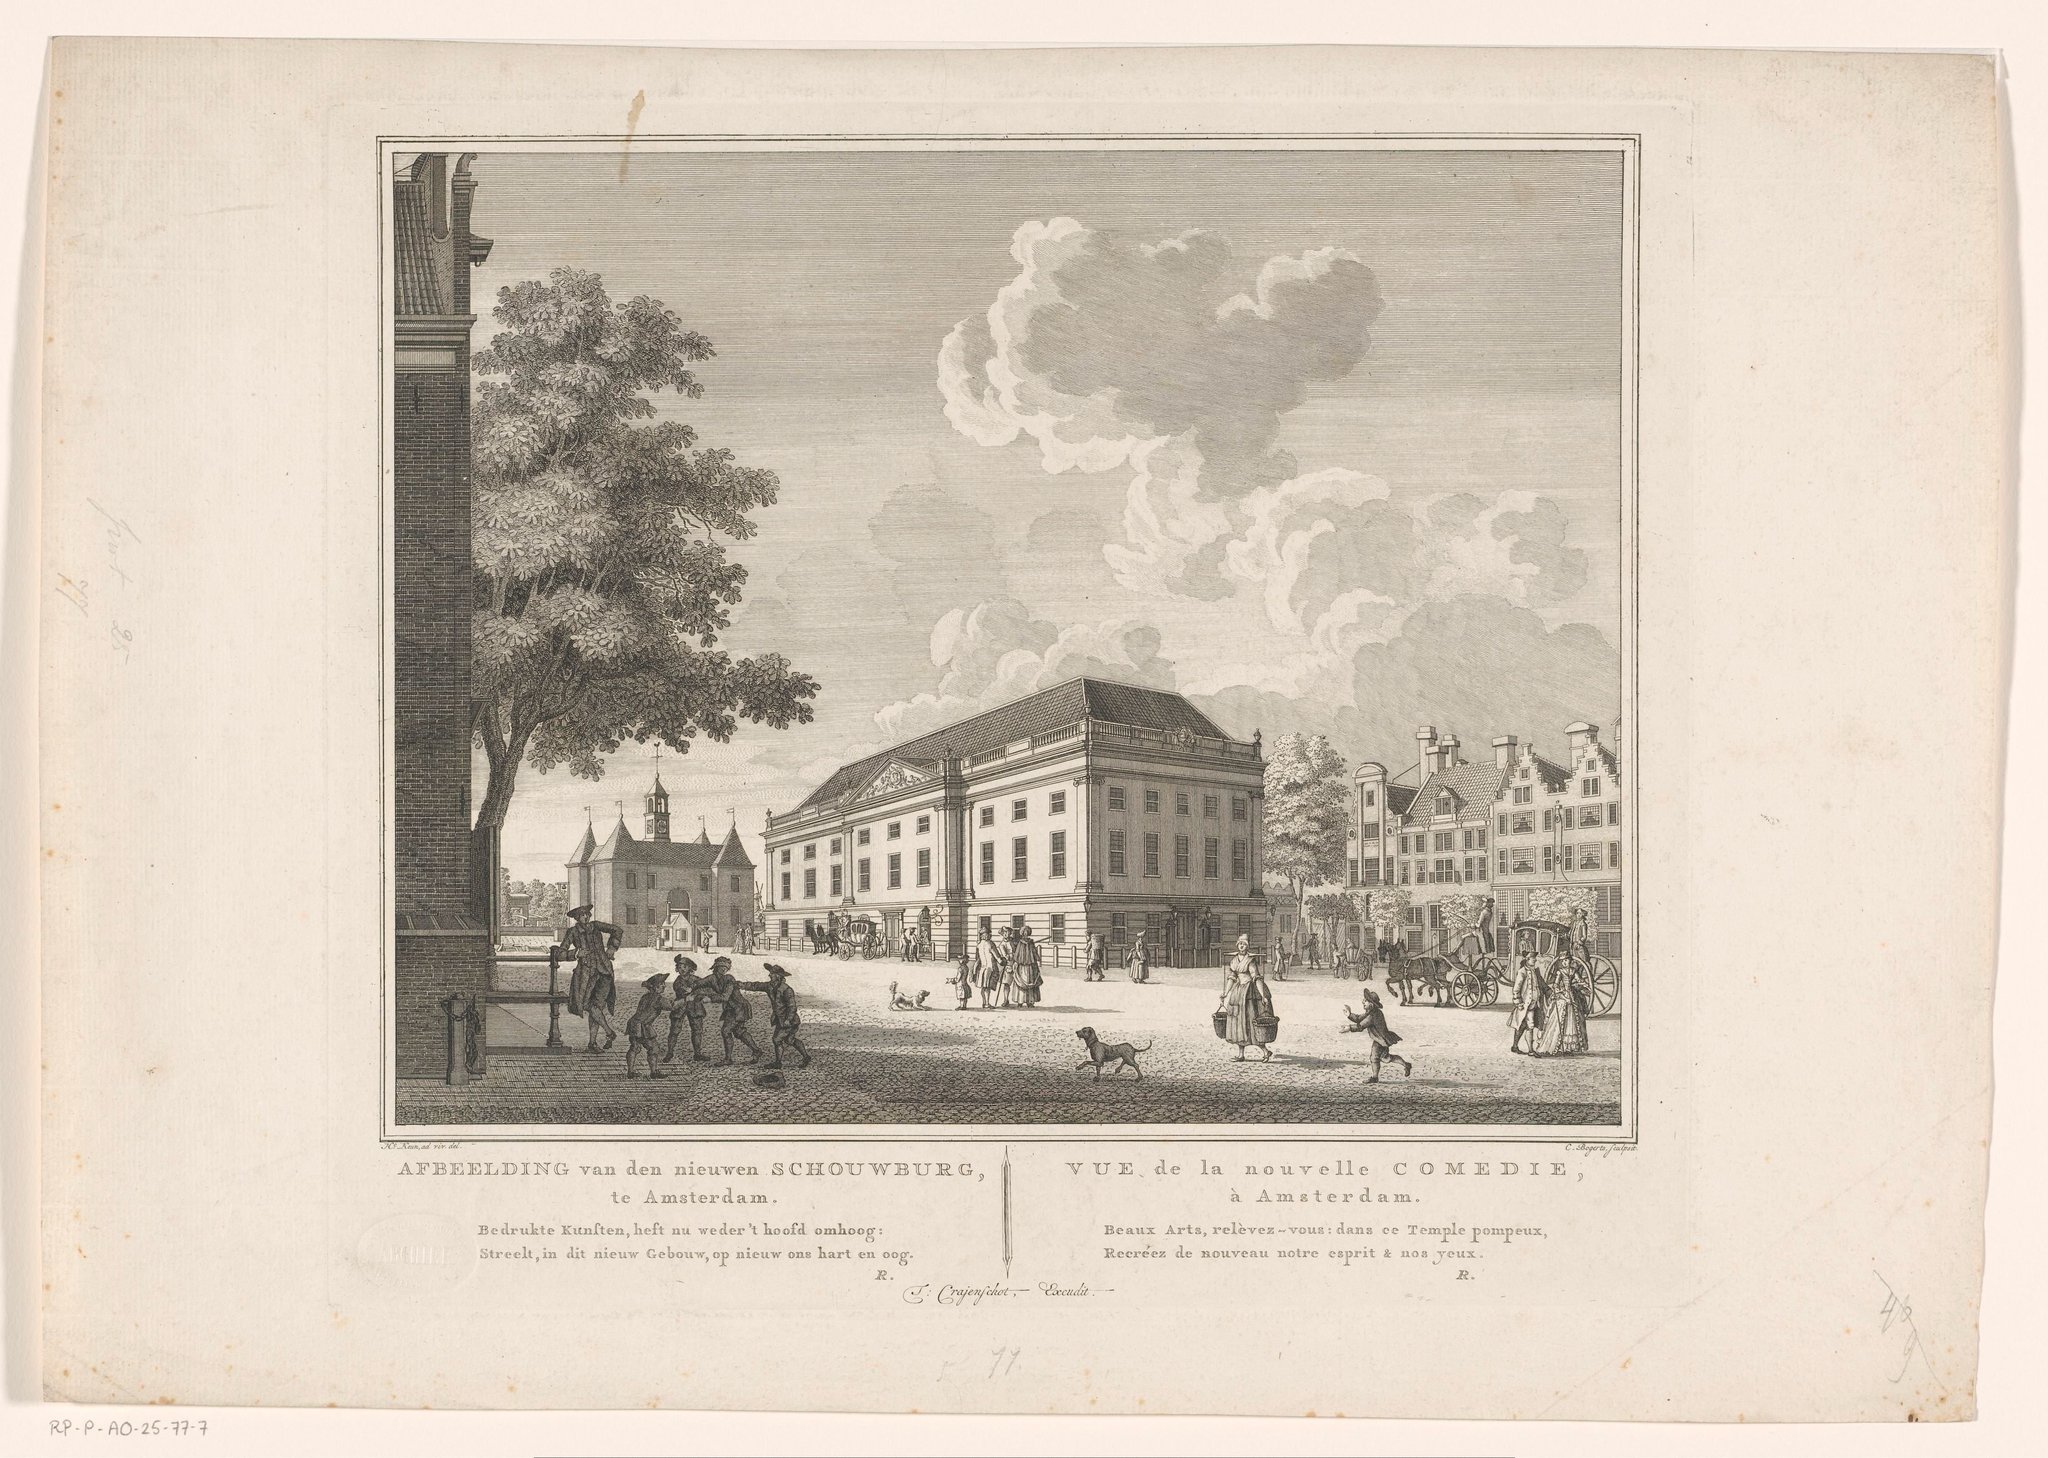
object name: print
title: Gezicht op de schouwburg aan het Leidseplein te Amsterdam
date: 1774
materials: paper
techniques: engraving, etching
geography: amsterdam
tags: theatre (building), city-gate, square, place, circus, etc. (+ city(-scape) with figures, staffage)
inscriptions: check stamp: ‘Archief Ministerie van Oorlog Afdeeling Genie’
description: Gezicht op de op 15 september 1774 ingewijde Amsterdamse Schouwburg op het Leidseplein. Op het plein verschillende figuren en koetsen. Links op de achtergrond de Leidsepoort. Deze stadsschouwburg werd gebouwd om de in 1772 afgebrande schouwburg aan de Keizersgracht te vervangen en brandde in 1890 zelf af. Onder de voorstelling de titel en een tweeregelig vers in het Nederlands (links) en Frans (rechts).